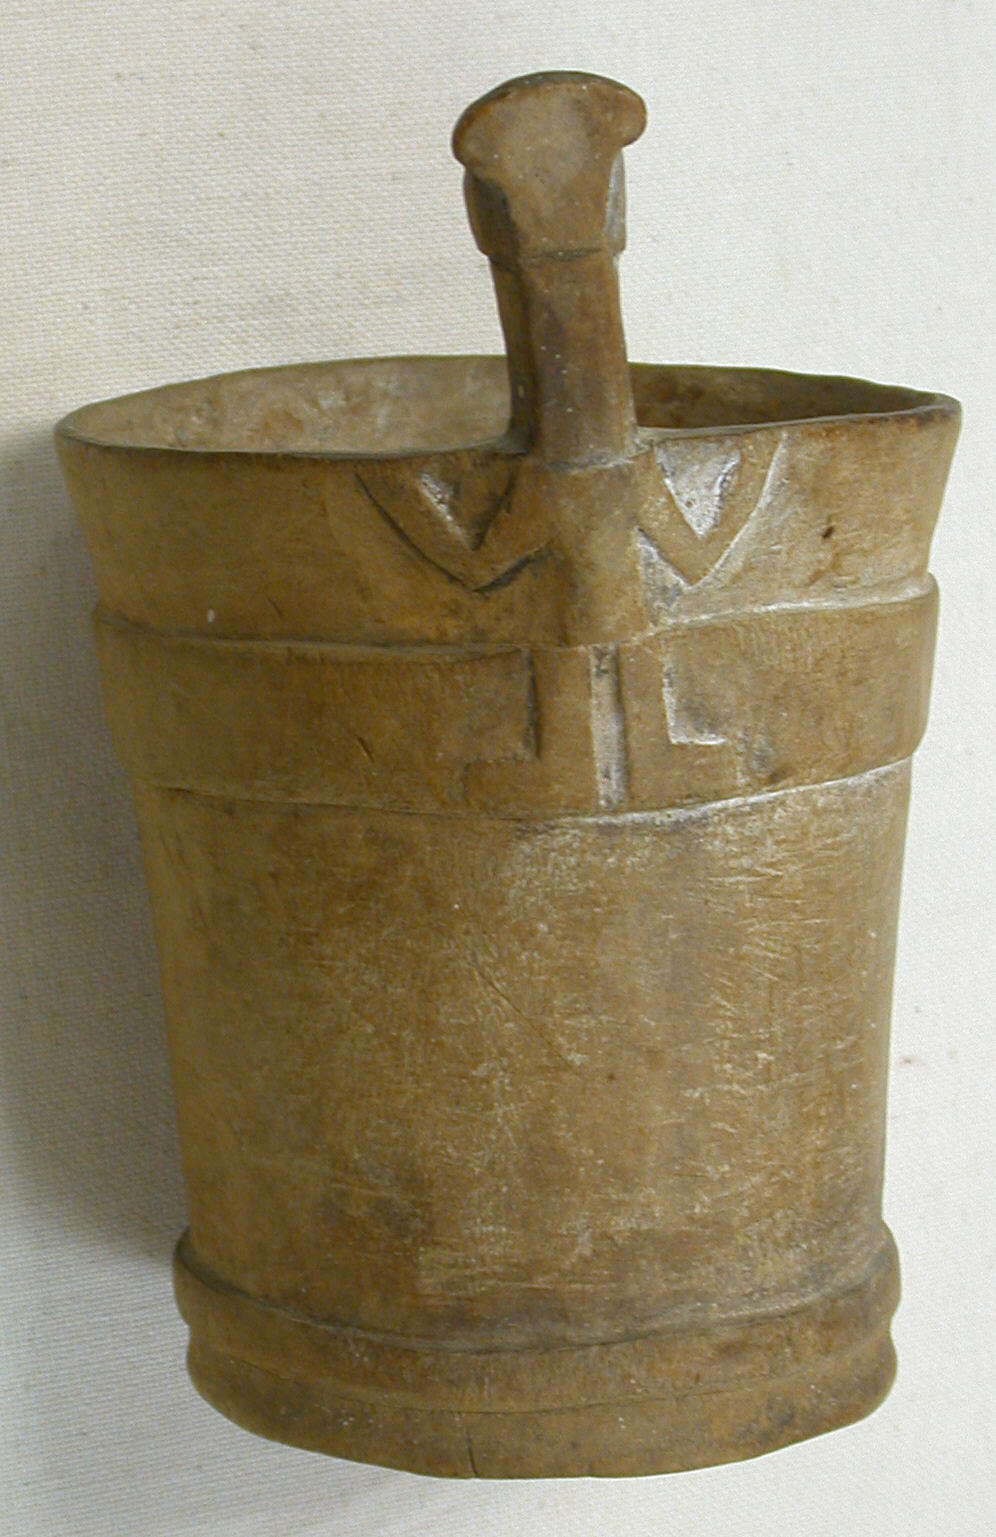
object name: beaker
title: Kero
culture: colonial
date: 1501-1800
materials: wood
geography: peru